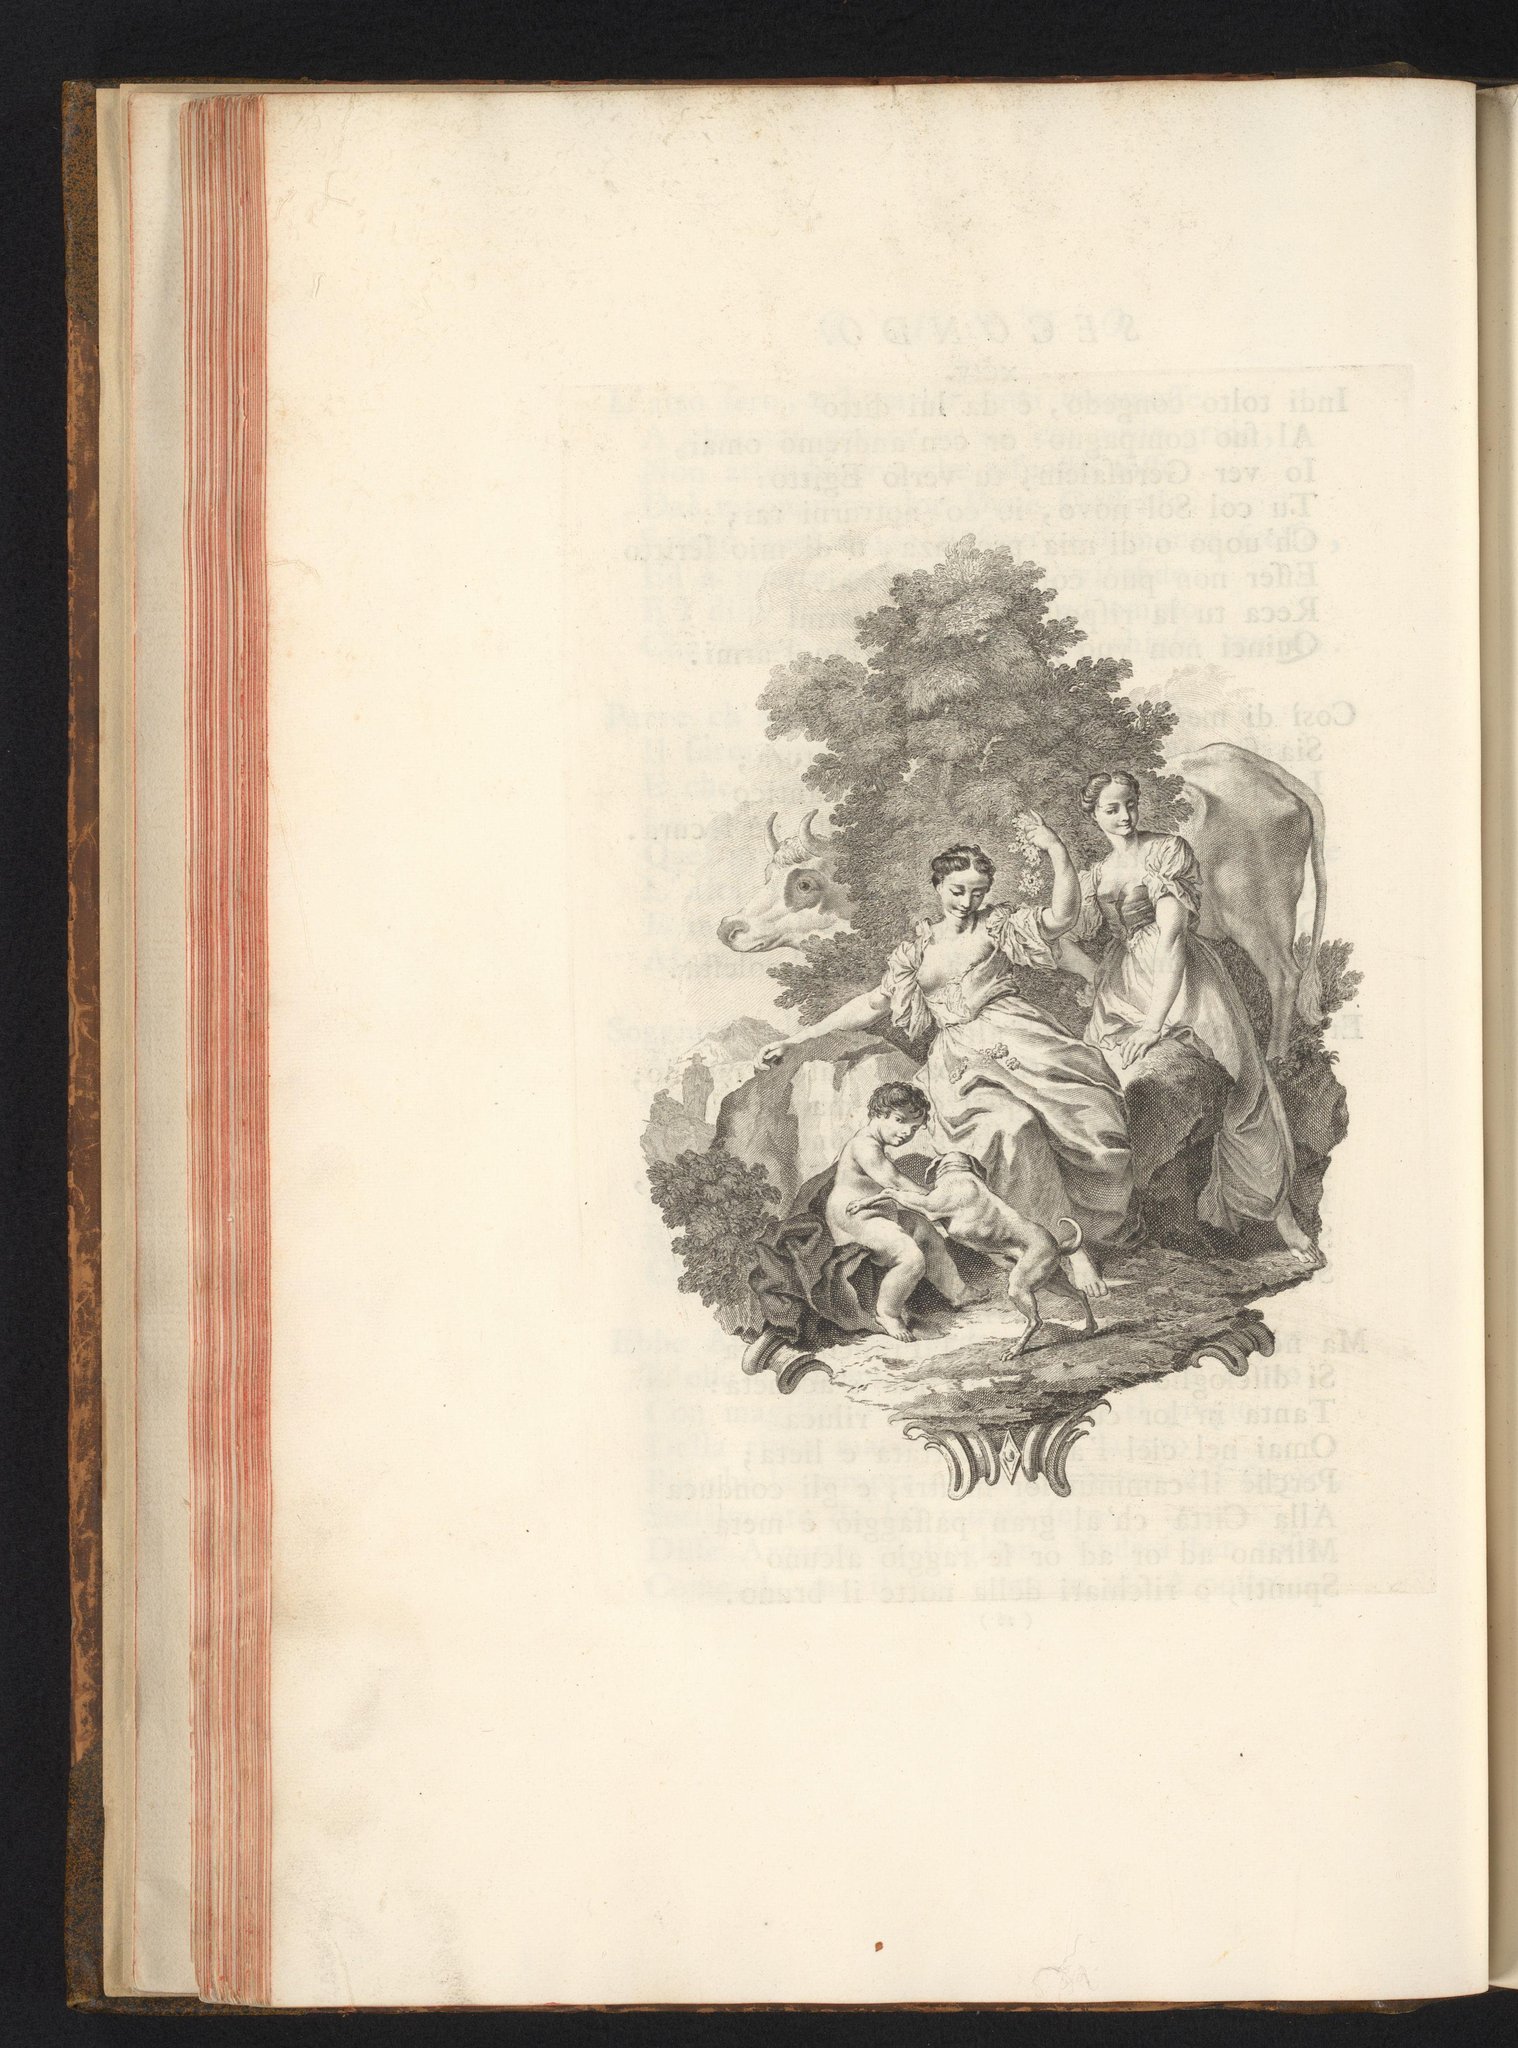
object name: page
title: Landschap met twee vrouwen, een stier en een jongen met hond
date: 1745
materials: paper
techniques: etching, letterpress printing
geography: venice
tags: bull, (scenes from) specific works of literature: tasso, gerusalemme liberata, landscapes (+ landscape with figures, staffage)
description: Prent uit: Tasso, Torquato. La Gerusalemme liberata di Torquato Tasso con le figure de Giambatista Piazzetta. Venetië: Giambatista Albrizzi, 1745.